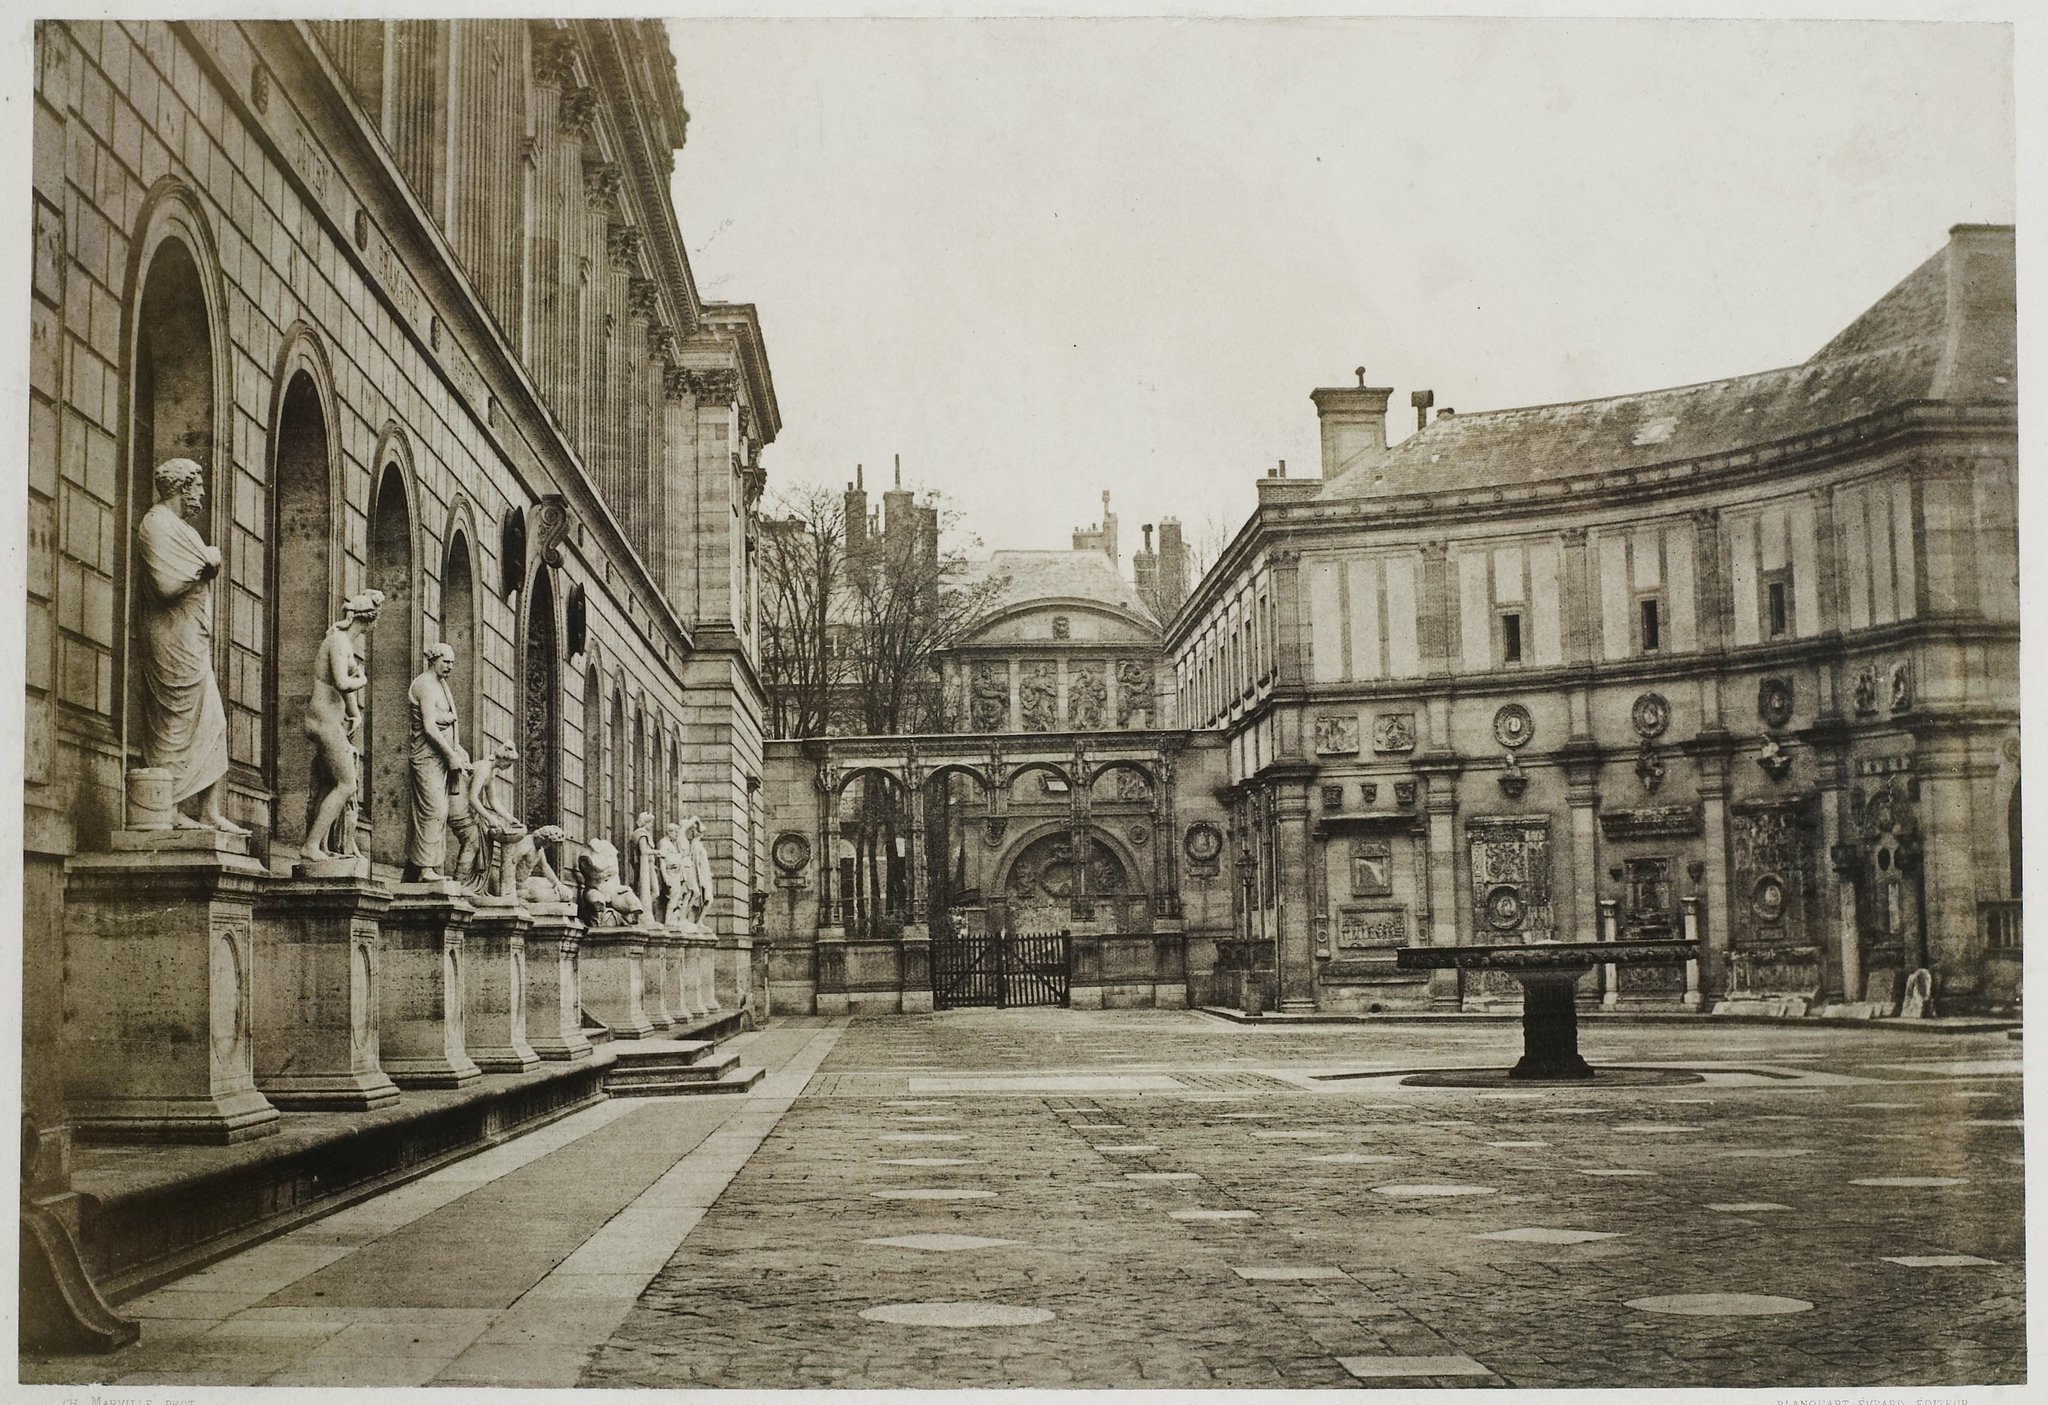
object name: photograph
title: Palais de l'École des Beaux-Arts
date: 1850-1851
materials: cardboard, photographic support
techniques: salted paper print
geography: lille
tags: palais de l'école des beaux-arts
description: Variant (RP-F-1997-48) werd in 1851 gepubliceerd in Album photographique de l'Artiste et de l'Amateur